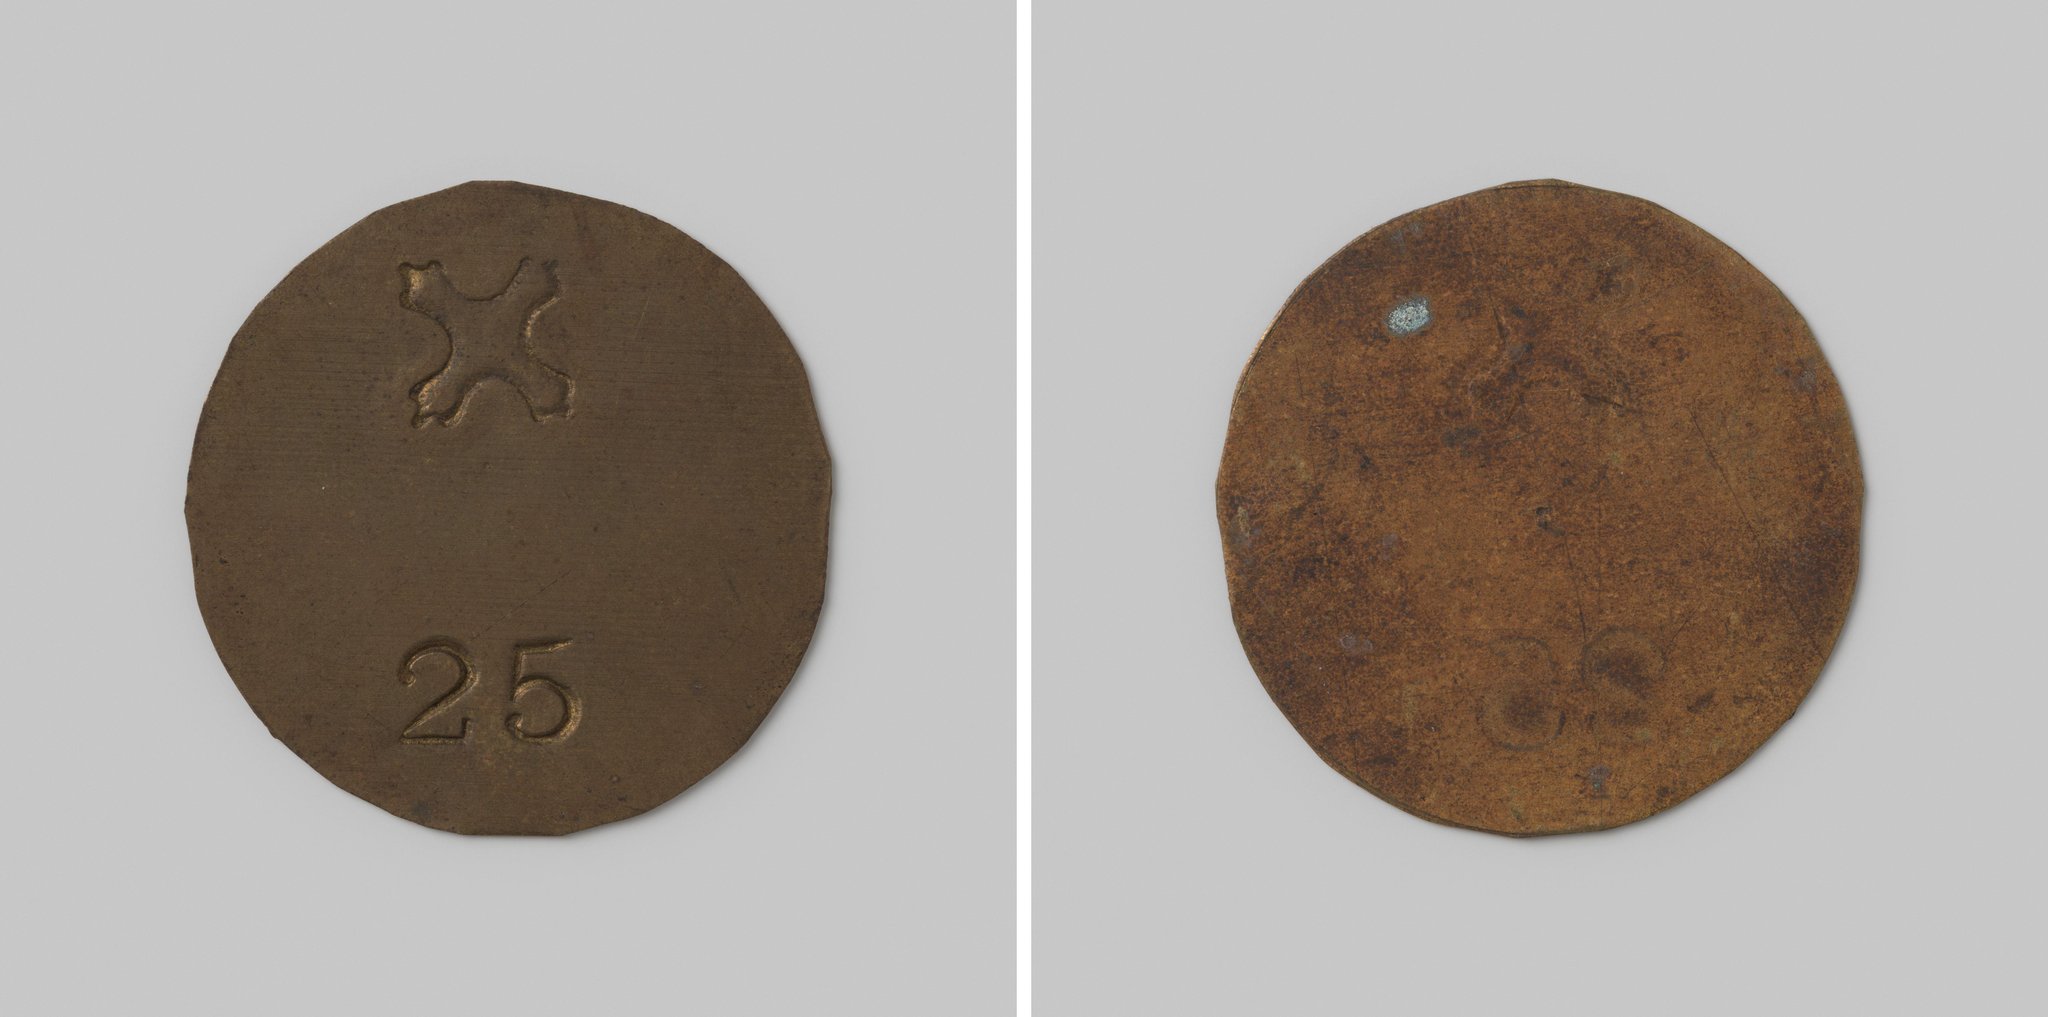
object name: vijfentwintig cent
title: Betaalpenning van vijfentwintig cent van de Coöperatieve Winkelvereeniging De Volharding te Veenendaal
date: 1875-1900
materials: brass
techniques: printing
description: Rond messing plaatje met instempelingen (andreaskruis) / 25